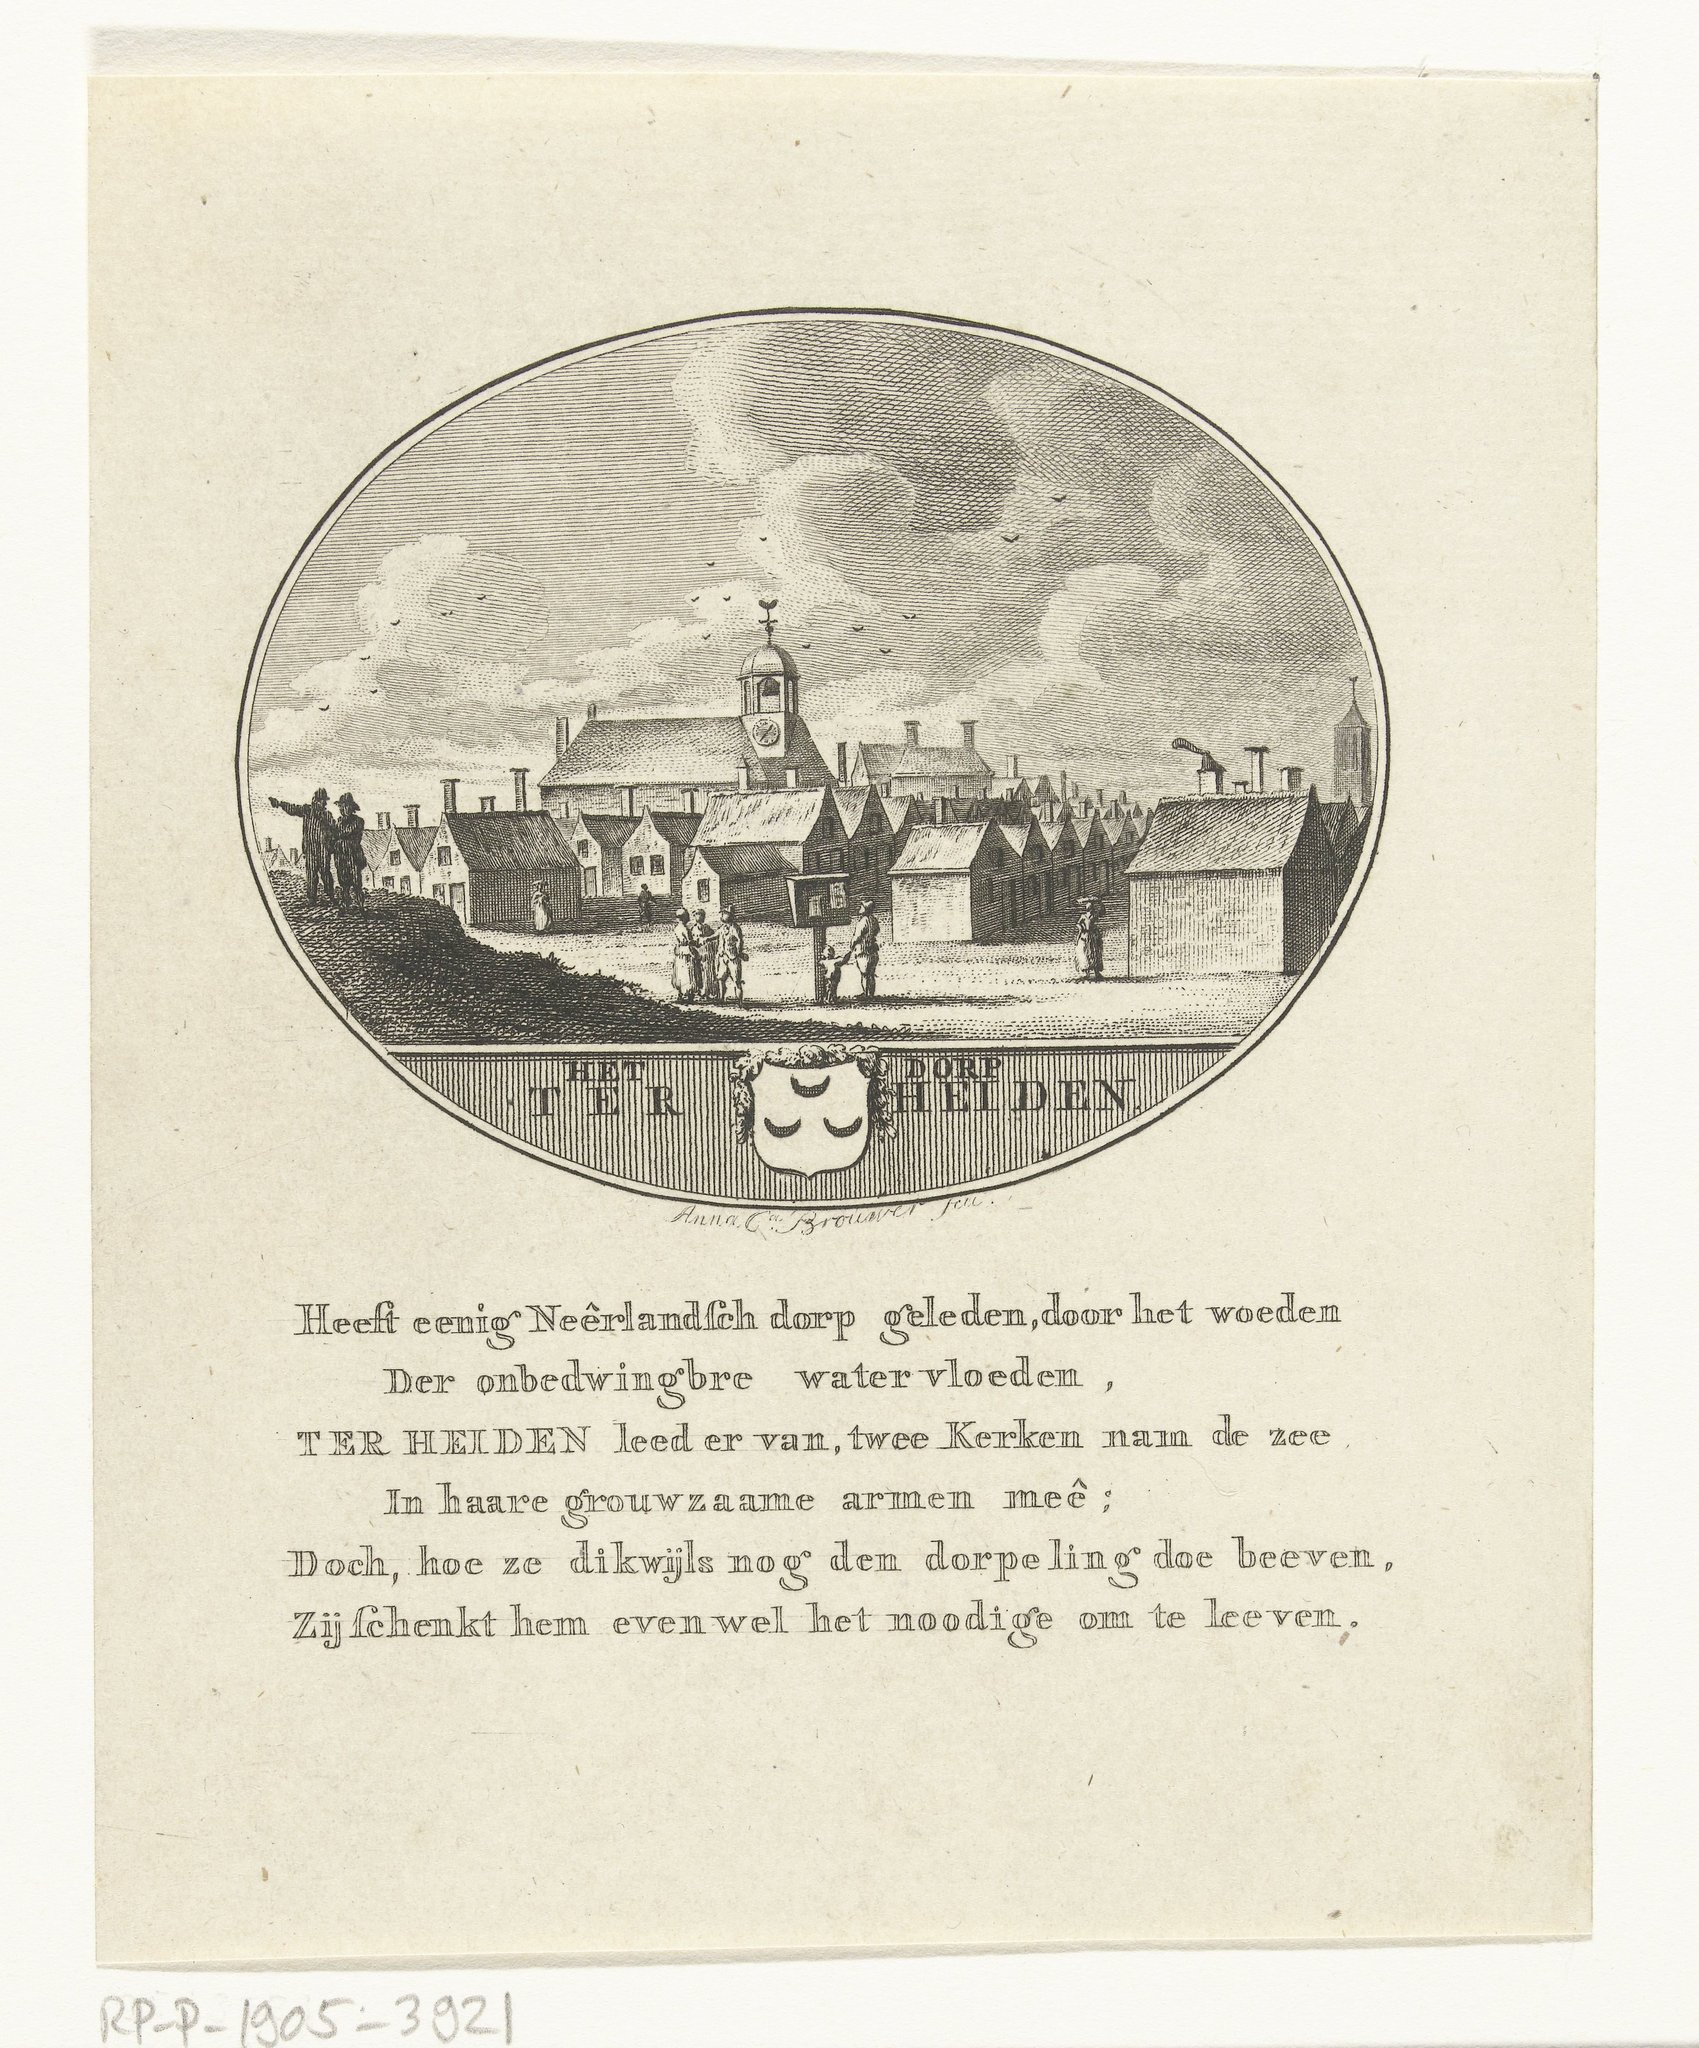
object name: print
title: Gezicht op het dorp Ter Heijde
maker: anna catharina brouwer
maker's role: print maker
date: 1791-1793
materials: paper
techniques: etching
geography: amsterdam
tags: city-view in general; 'veduta', village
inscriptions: collector's mark: Lugt 2228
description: afkomstig uit: L. van Ollefen, De Nederlandsche stad- en dorpbeschrijver. Deel 2. Amsterdam: H.A. Banse, 1793